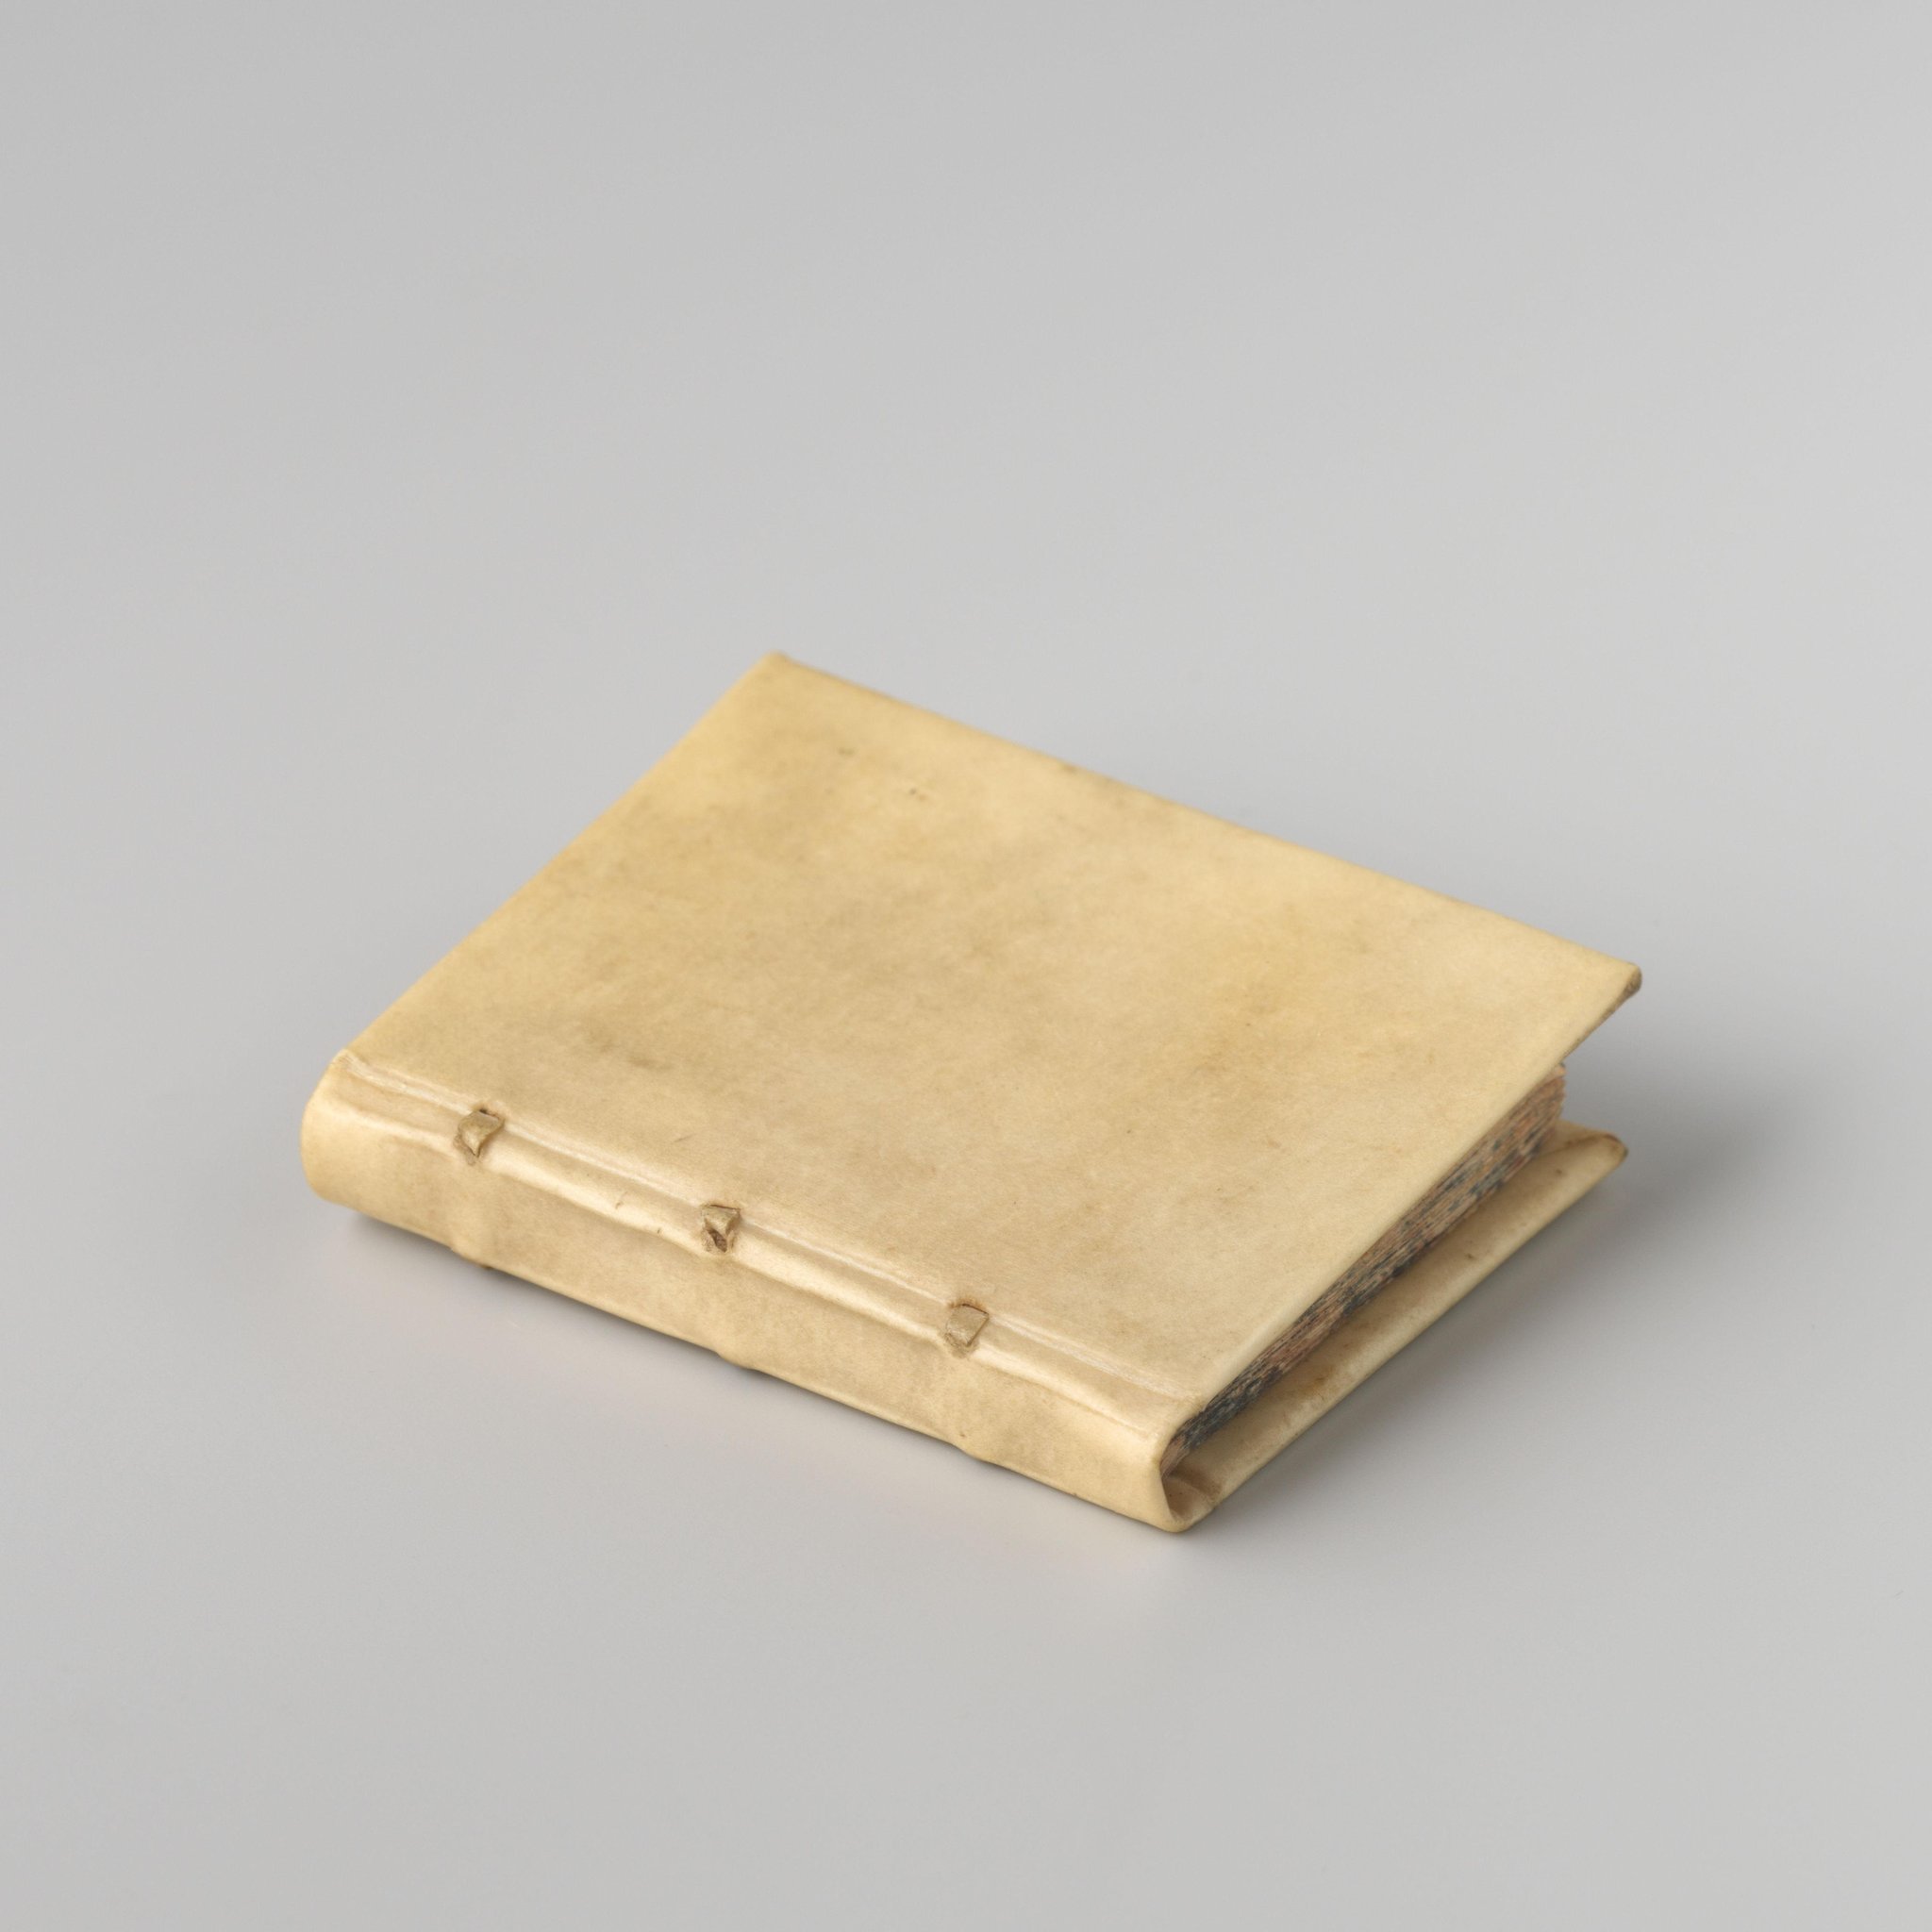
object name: book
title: Boek getiteld Tempus ridendi, Tempus flendi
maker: Anonymous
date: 1690-1710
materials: paper, parchment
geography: amsterdam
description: Boek getiteld Tempus ridendi, Tempus flendi. Ingebonden in blank perkament.